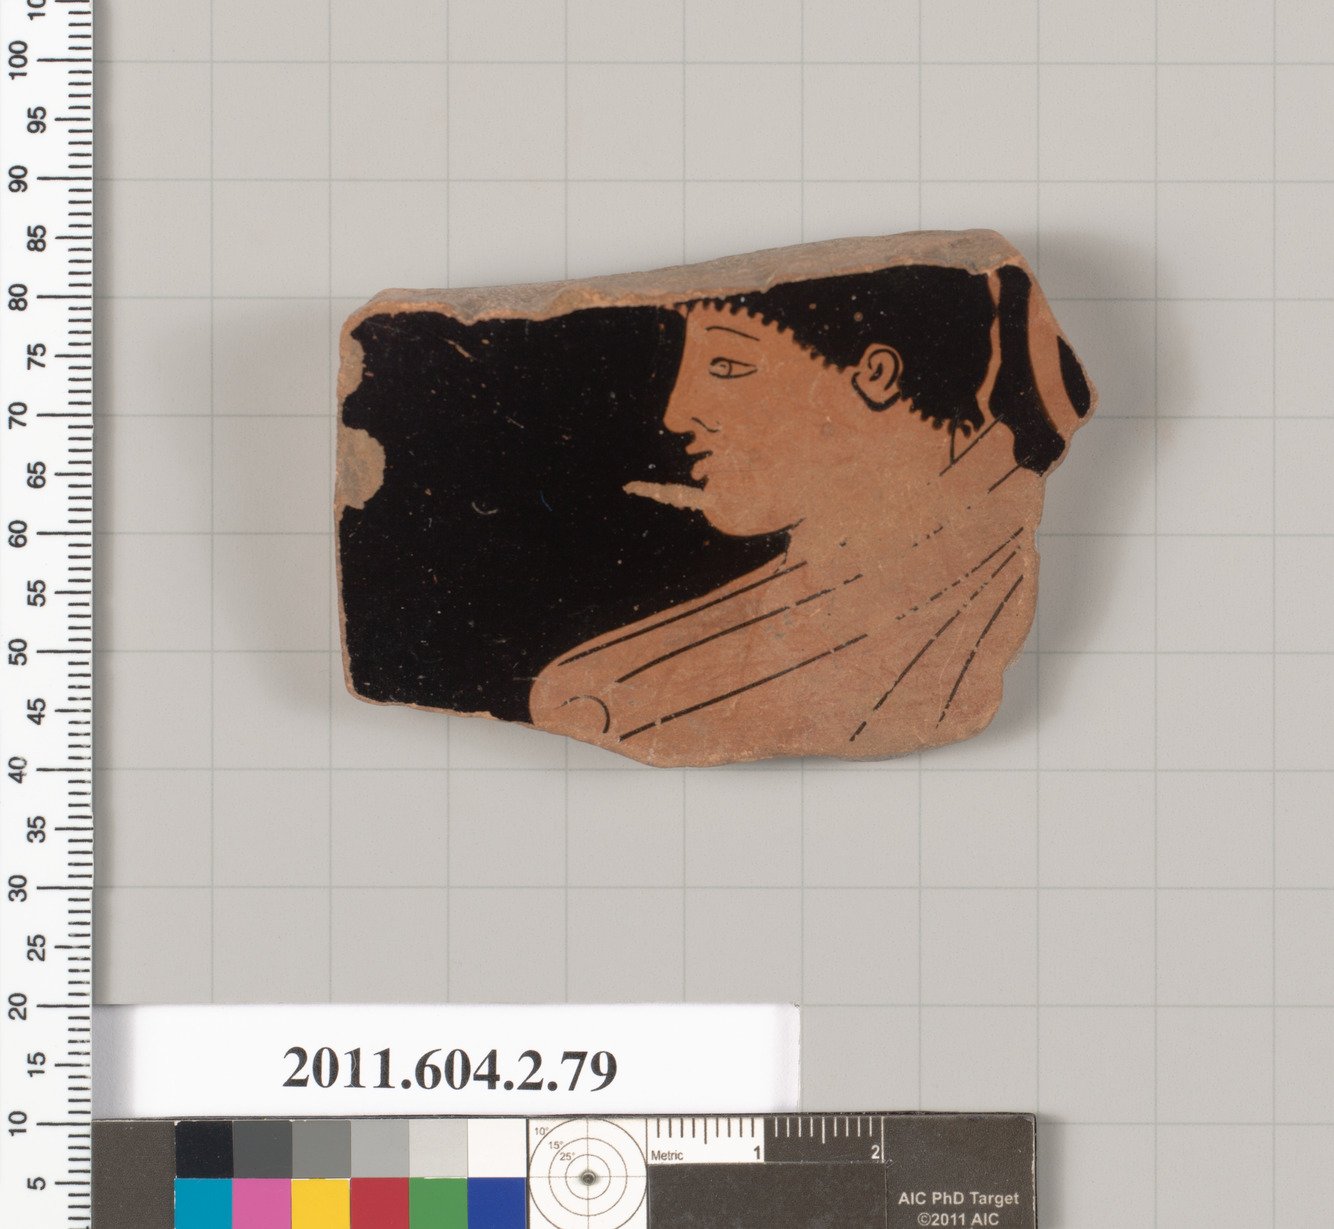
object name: pelike fragment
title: Terracotta fragment of a pelike (jar)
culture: greek, attic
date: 510-490 BCE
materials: terracotta